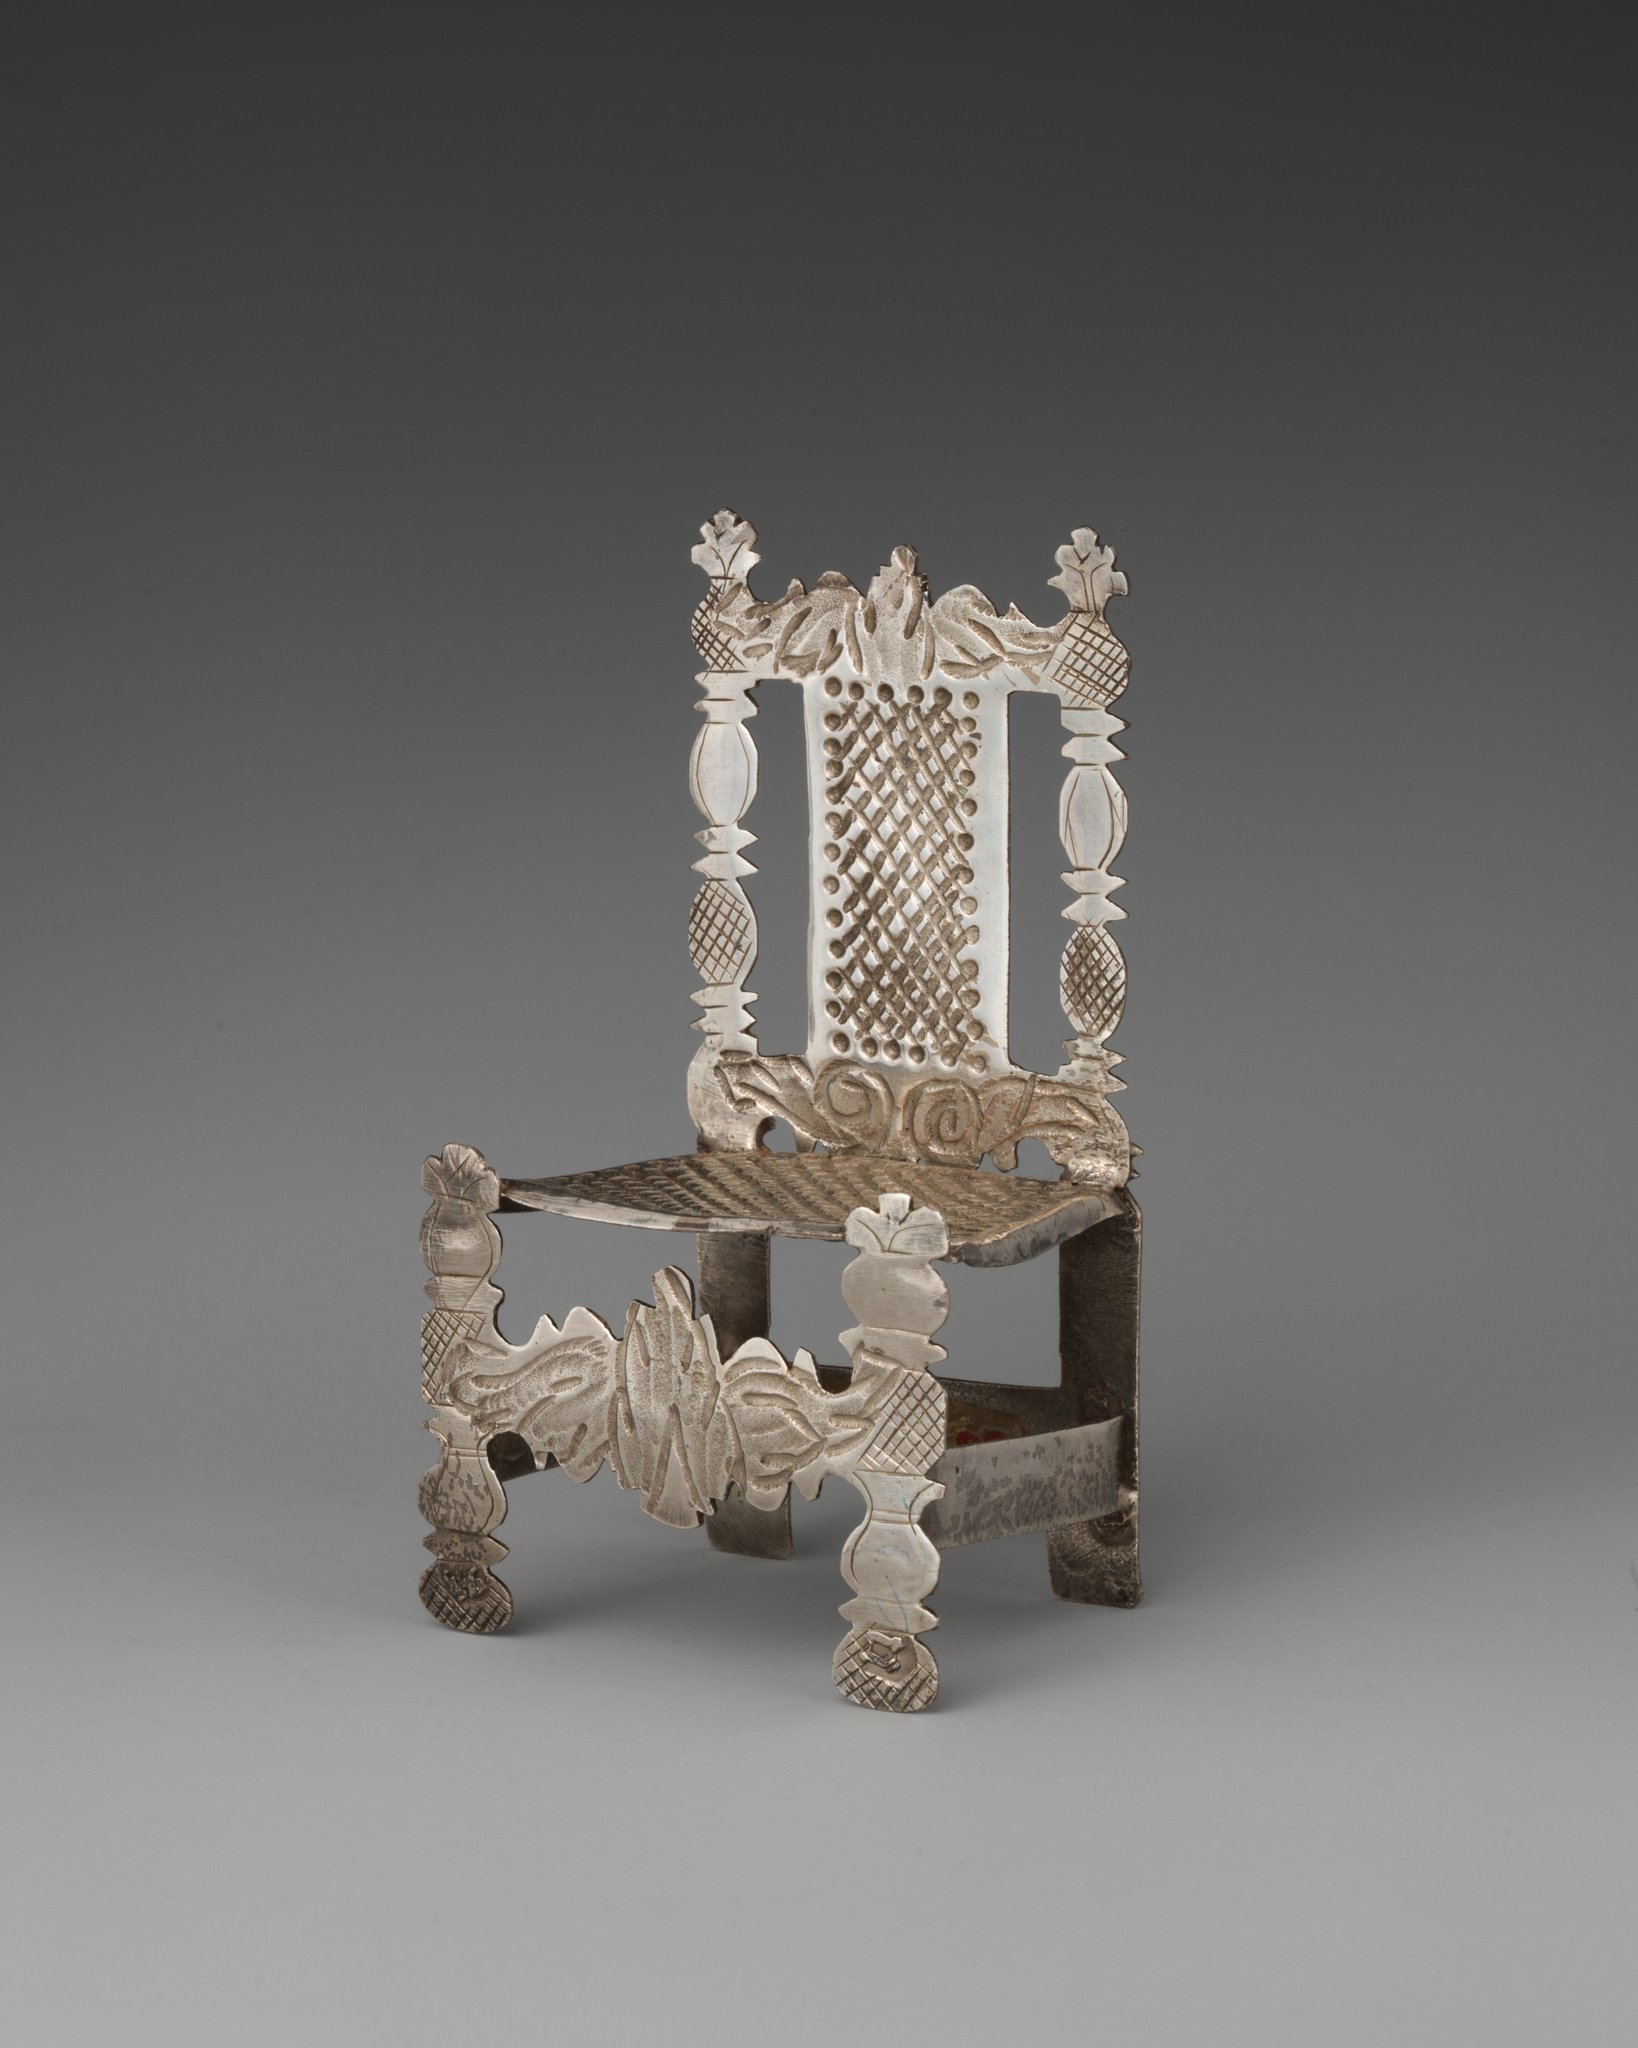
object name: chair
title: Miniature chair (one of four) (part of a set)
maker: george manjoy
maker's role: maker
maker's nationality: british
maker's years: 1685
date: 1690-1691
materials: silver